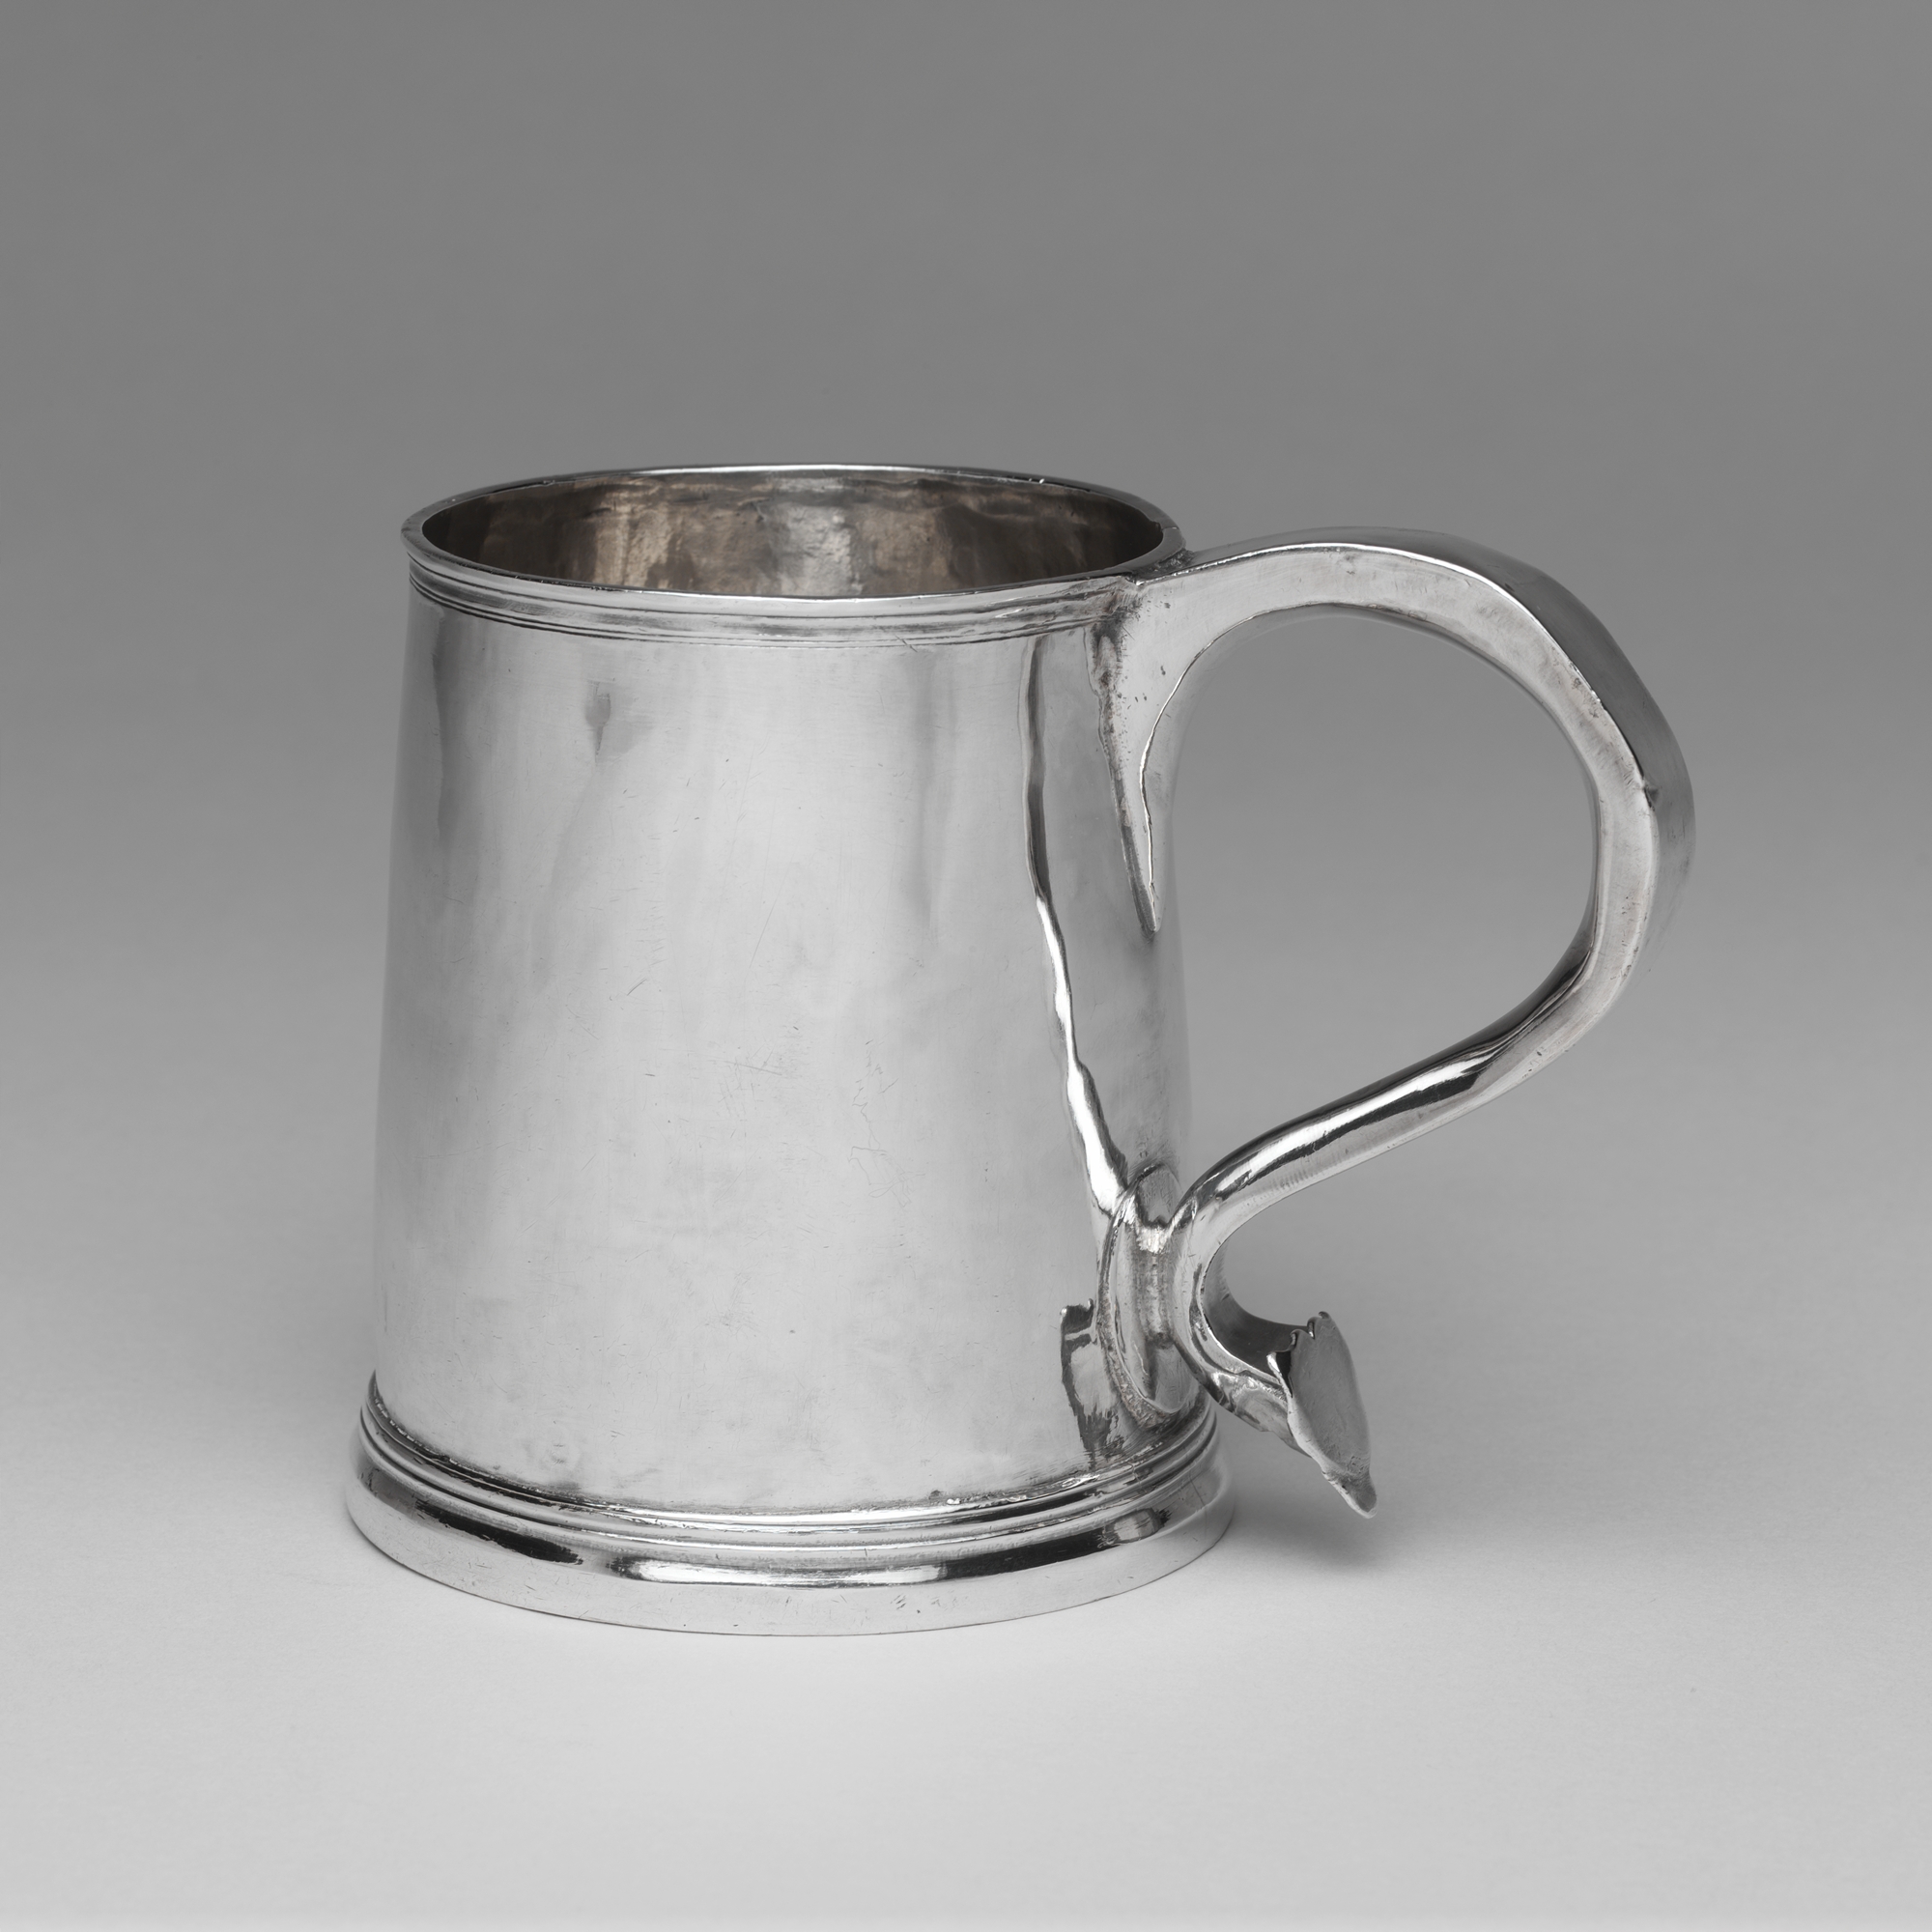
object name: mug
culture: american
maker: l. a.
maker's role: maker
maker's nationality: american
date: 1731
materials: silver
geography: united states